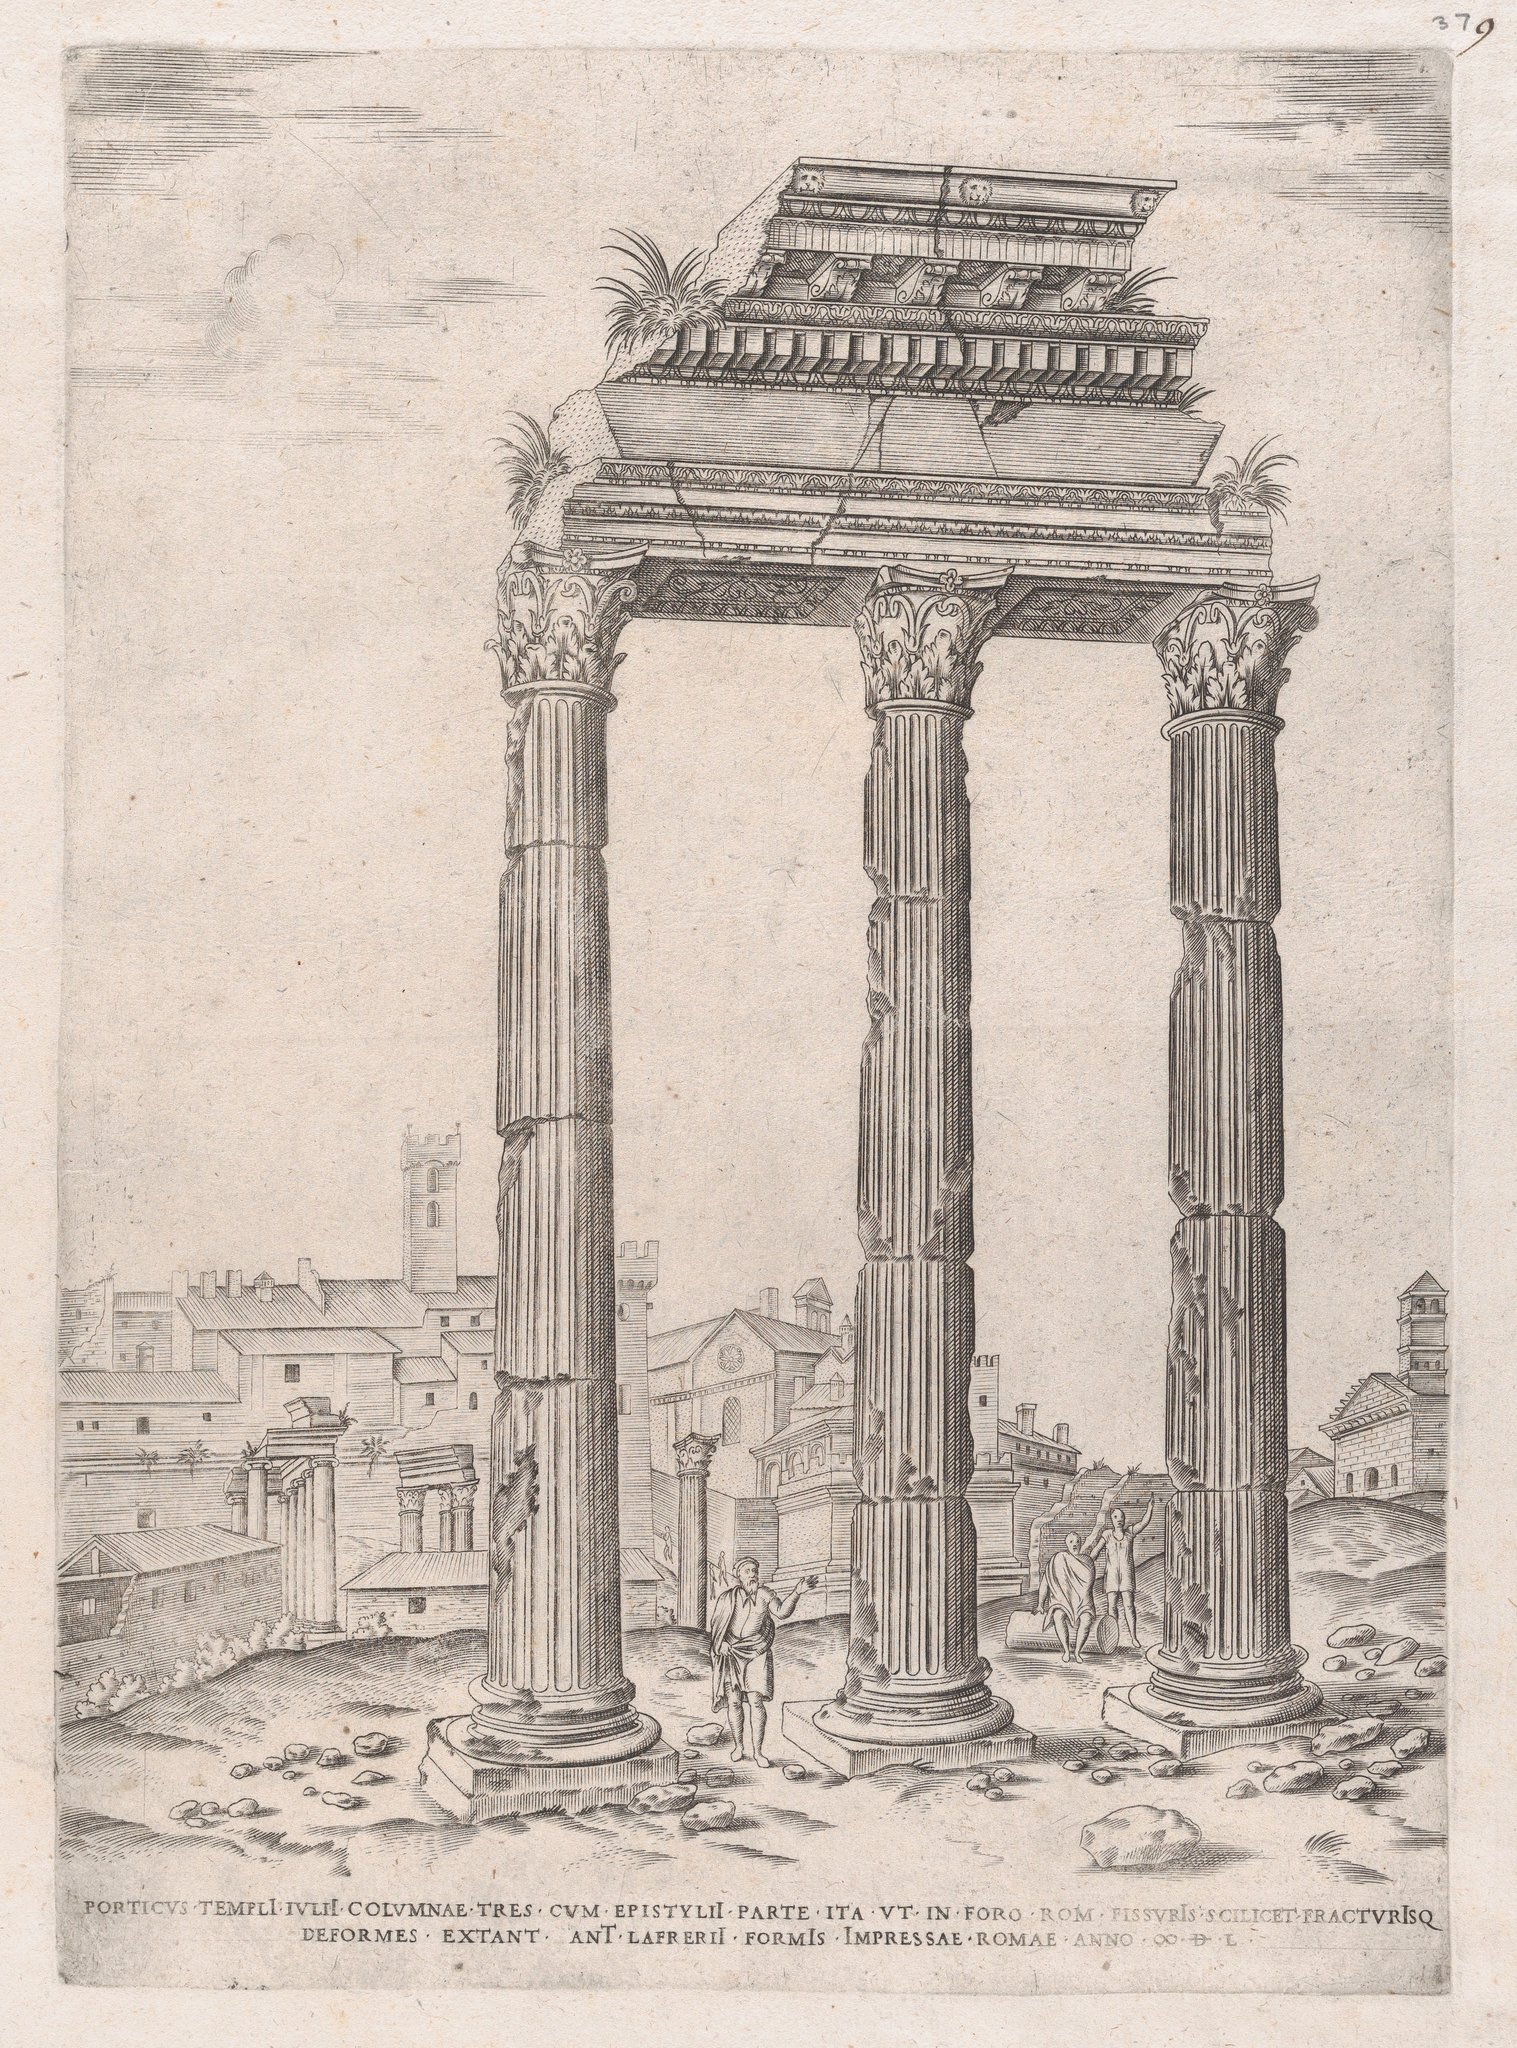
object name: print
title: Portico of the Temple of Julius, from "Speculum Romanae Magnificentiae"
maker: Anonymous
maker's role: artist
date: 1550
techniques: engraving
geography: rome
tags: columns,rome